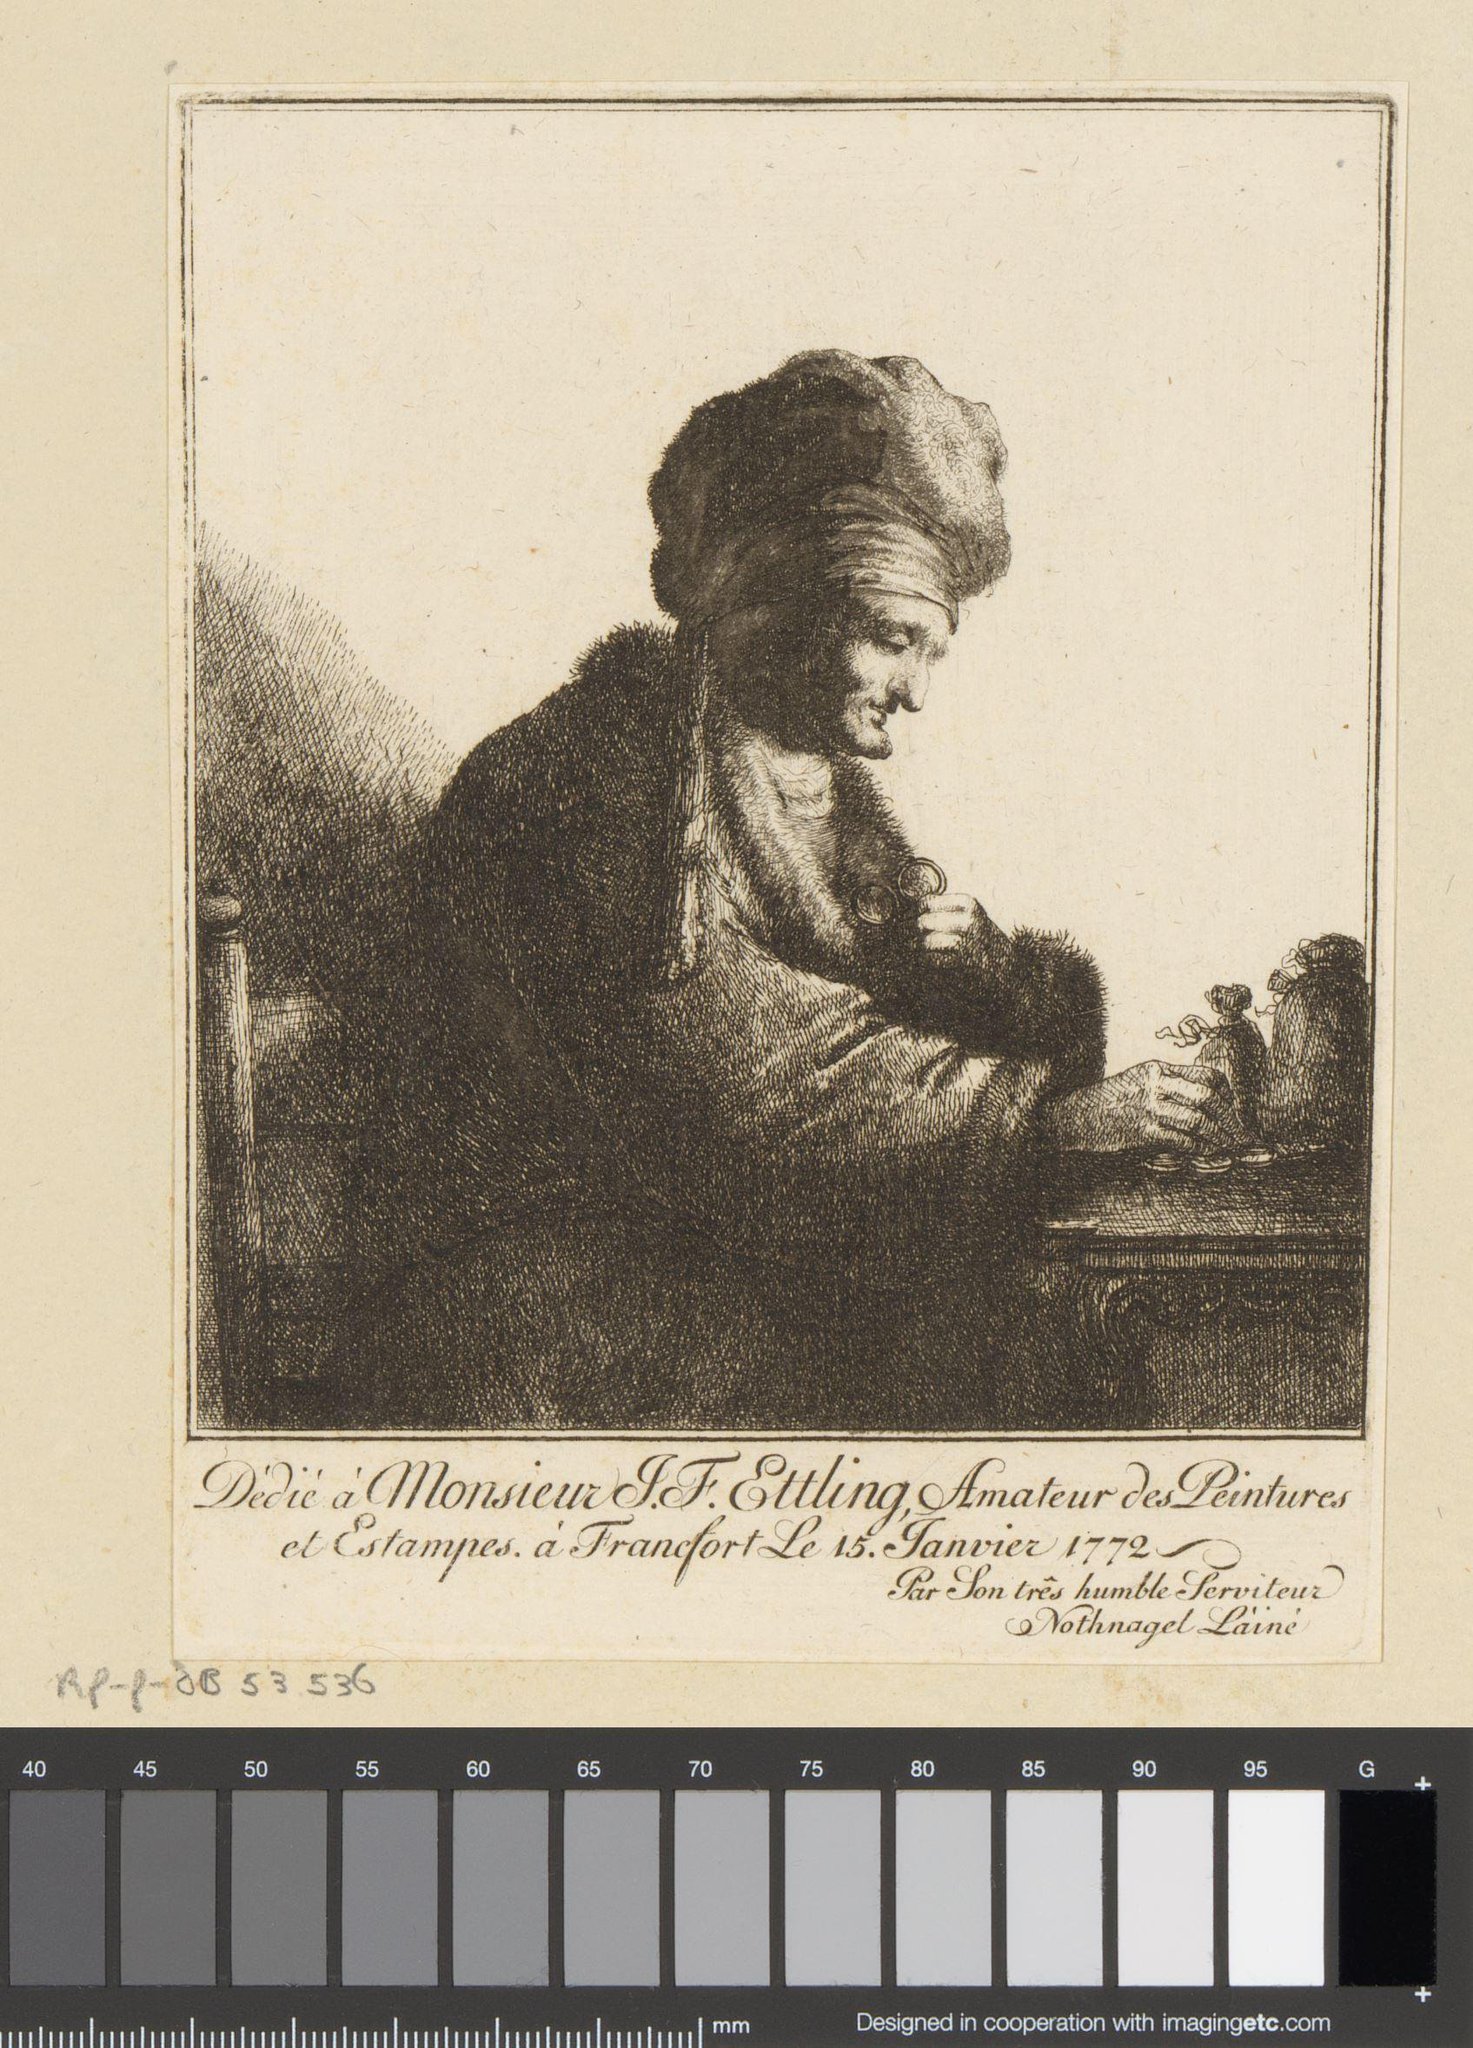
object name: print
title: Man met tulband en bril in de hand aan tafel waarop munten en buidels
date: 1772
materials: paper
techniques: etching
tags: eyeglasses, spectacles, sitting figure, head-gear: turban, money, counting, calculating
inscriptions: collector's mark: Lugt 240